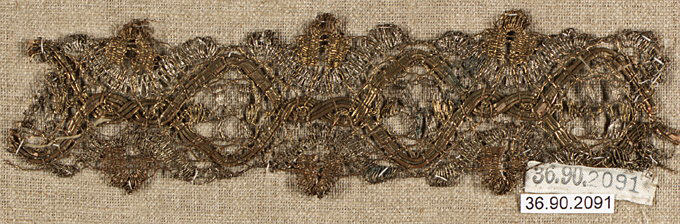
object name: piece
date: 1801-1900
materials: metal thread, silk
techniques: lace